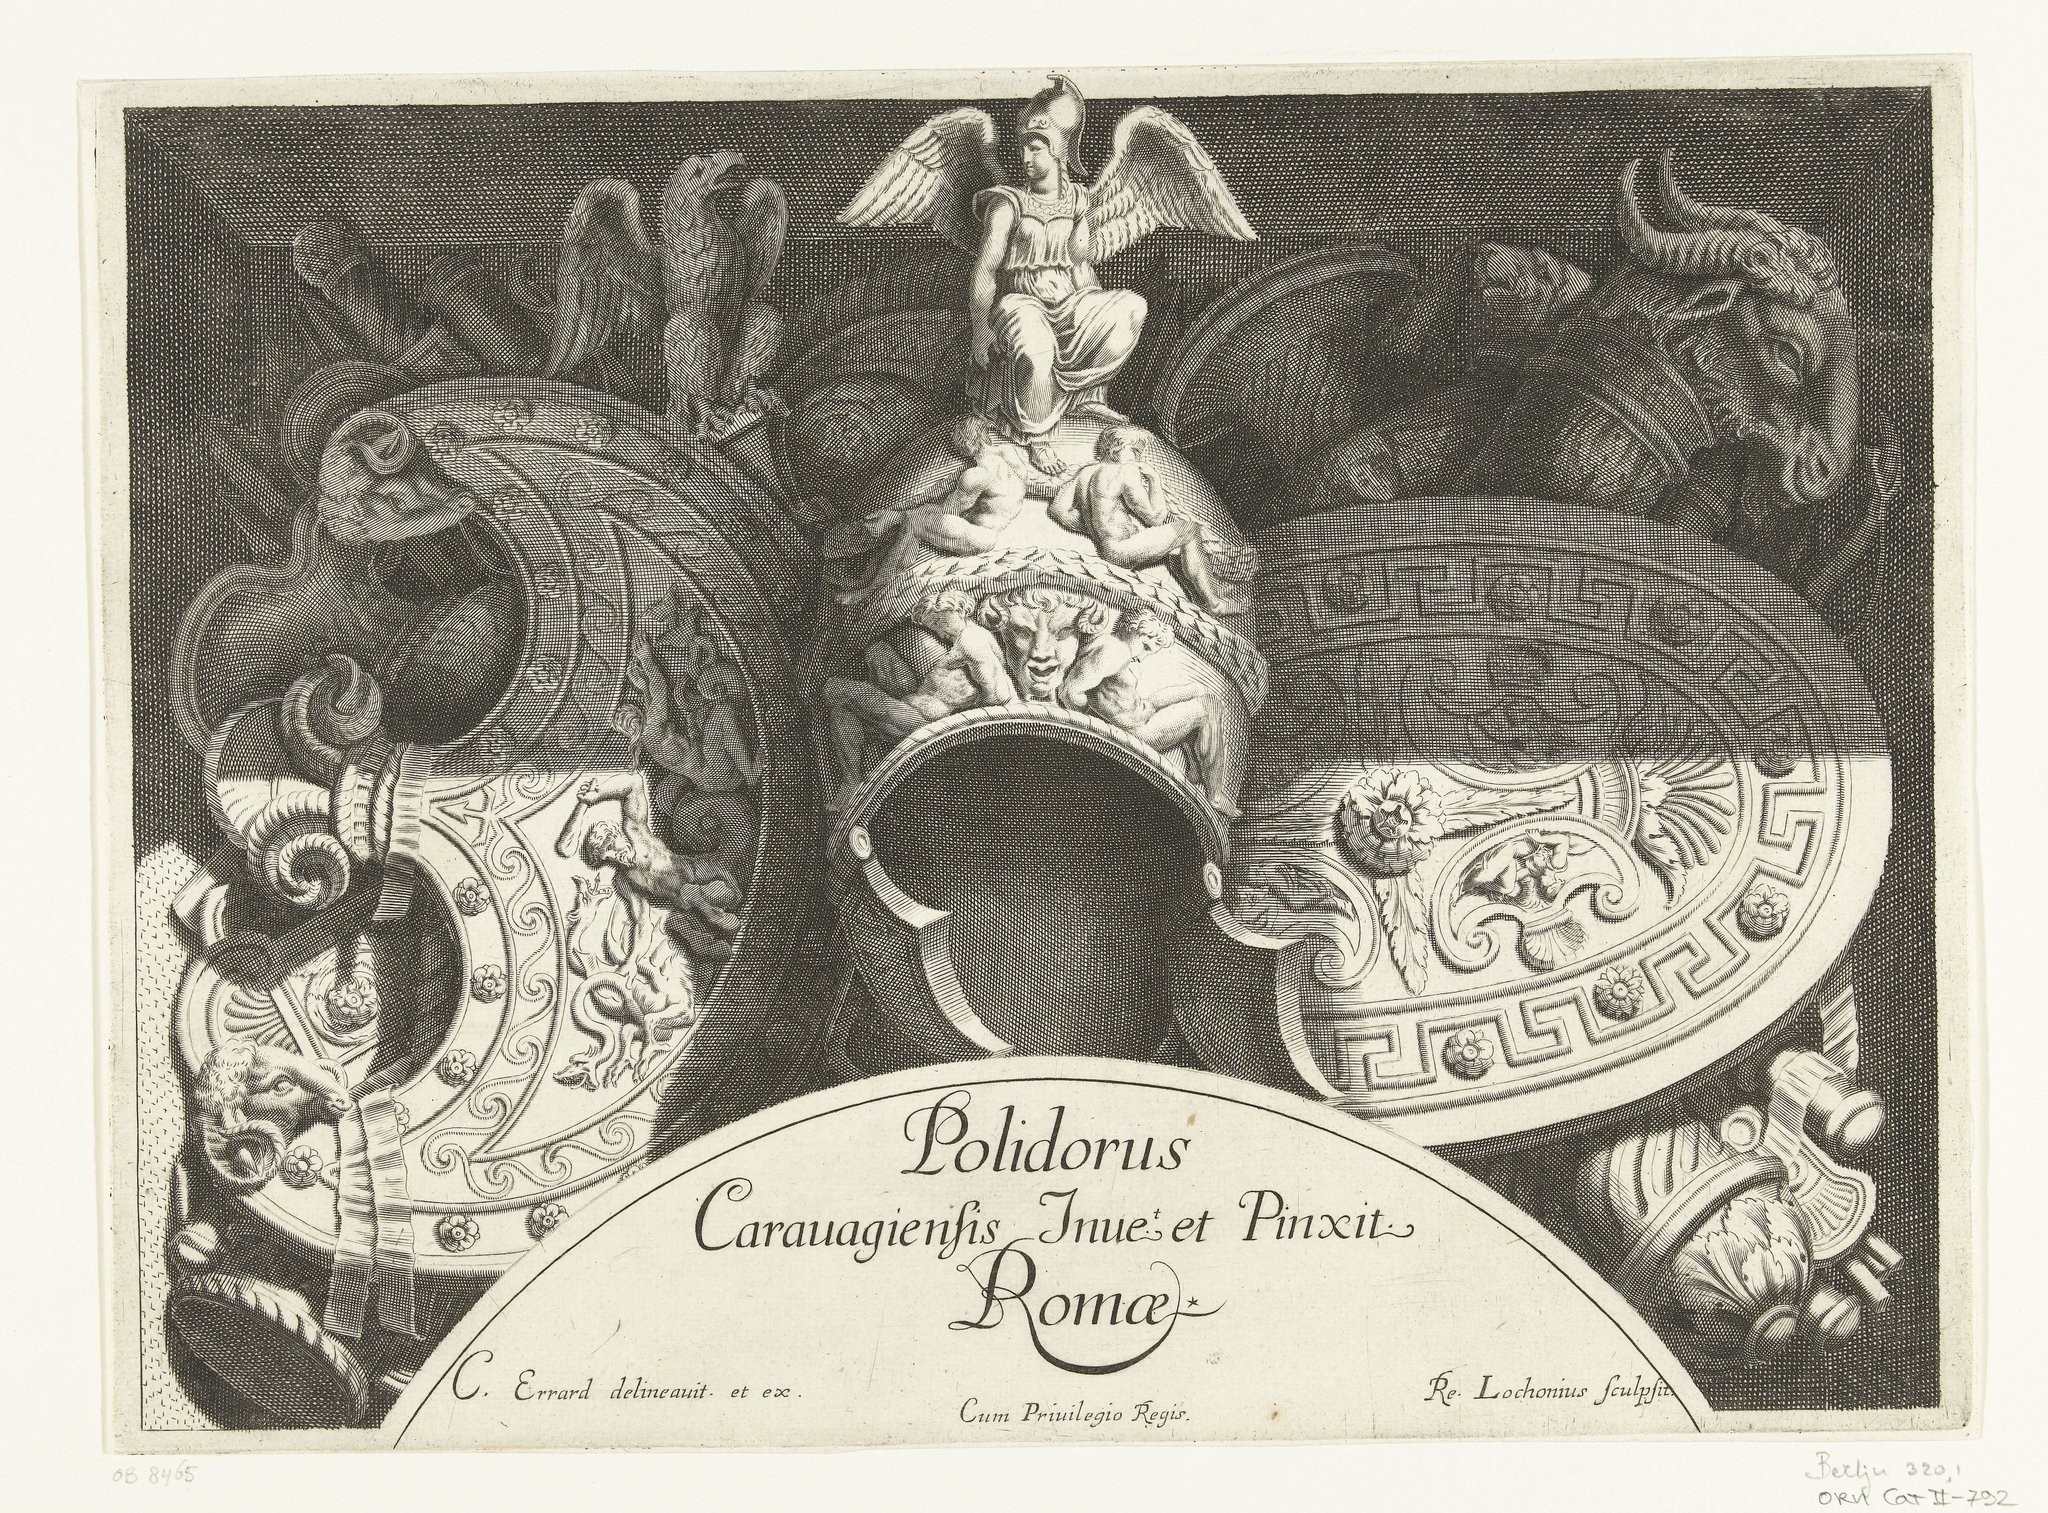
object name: print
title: Divers Trophées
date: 1651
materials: paper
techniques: engraving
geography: france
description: Nike heeft twee gevangenen aan haar voeten. Uit serie van titelblad en vijf bladen.